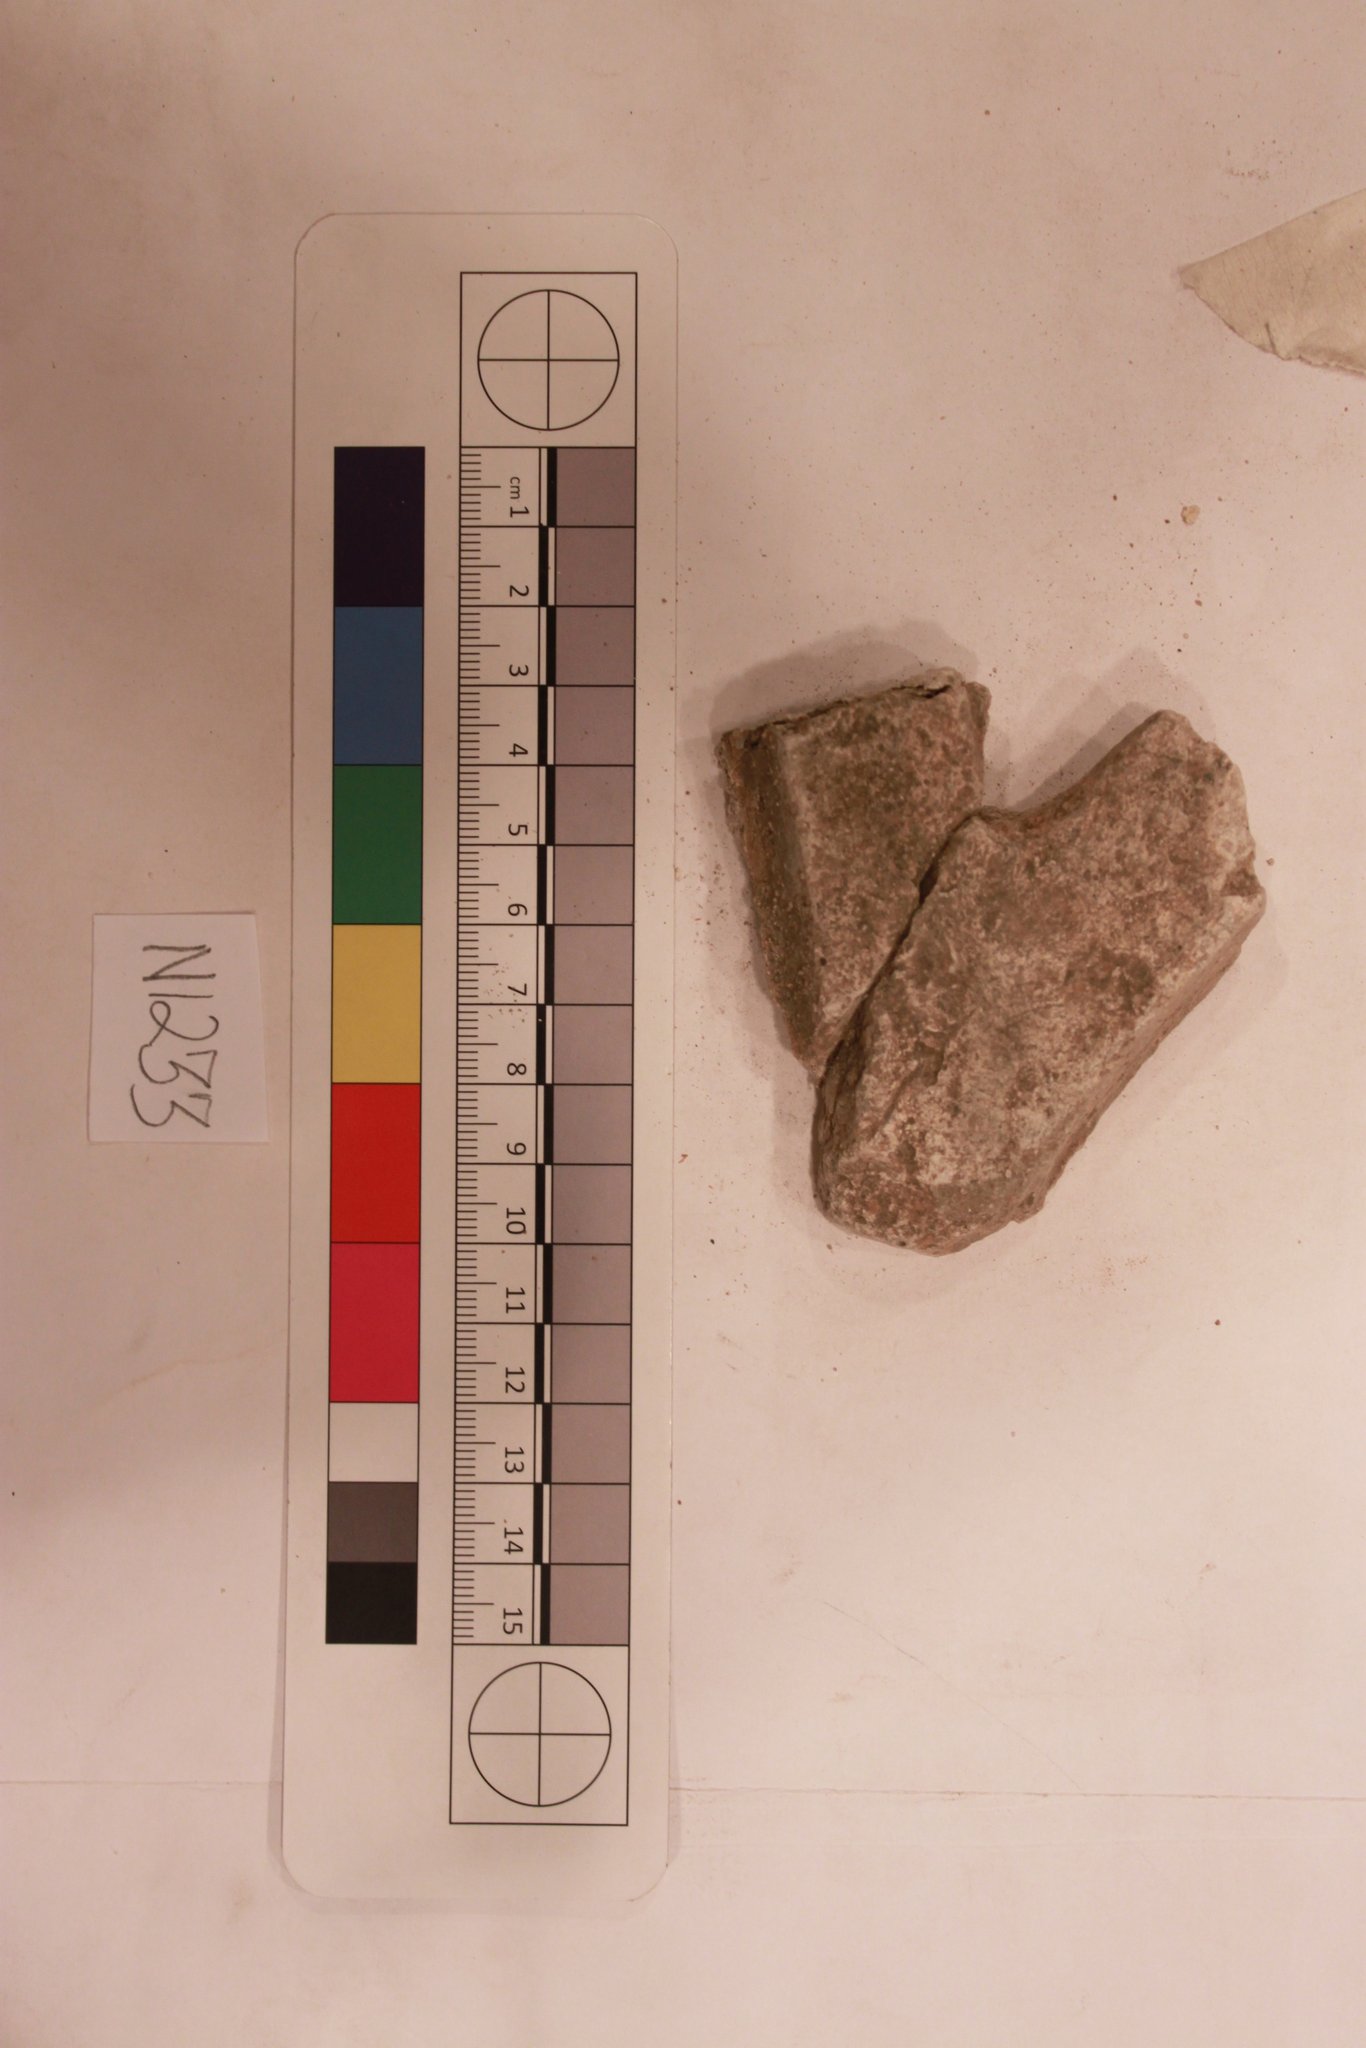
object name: fragment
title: Stucco Fragment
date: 701-1200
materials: plaster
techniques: carving, painting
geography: iran